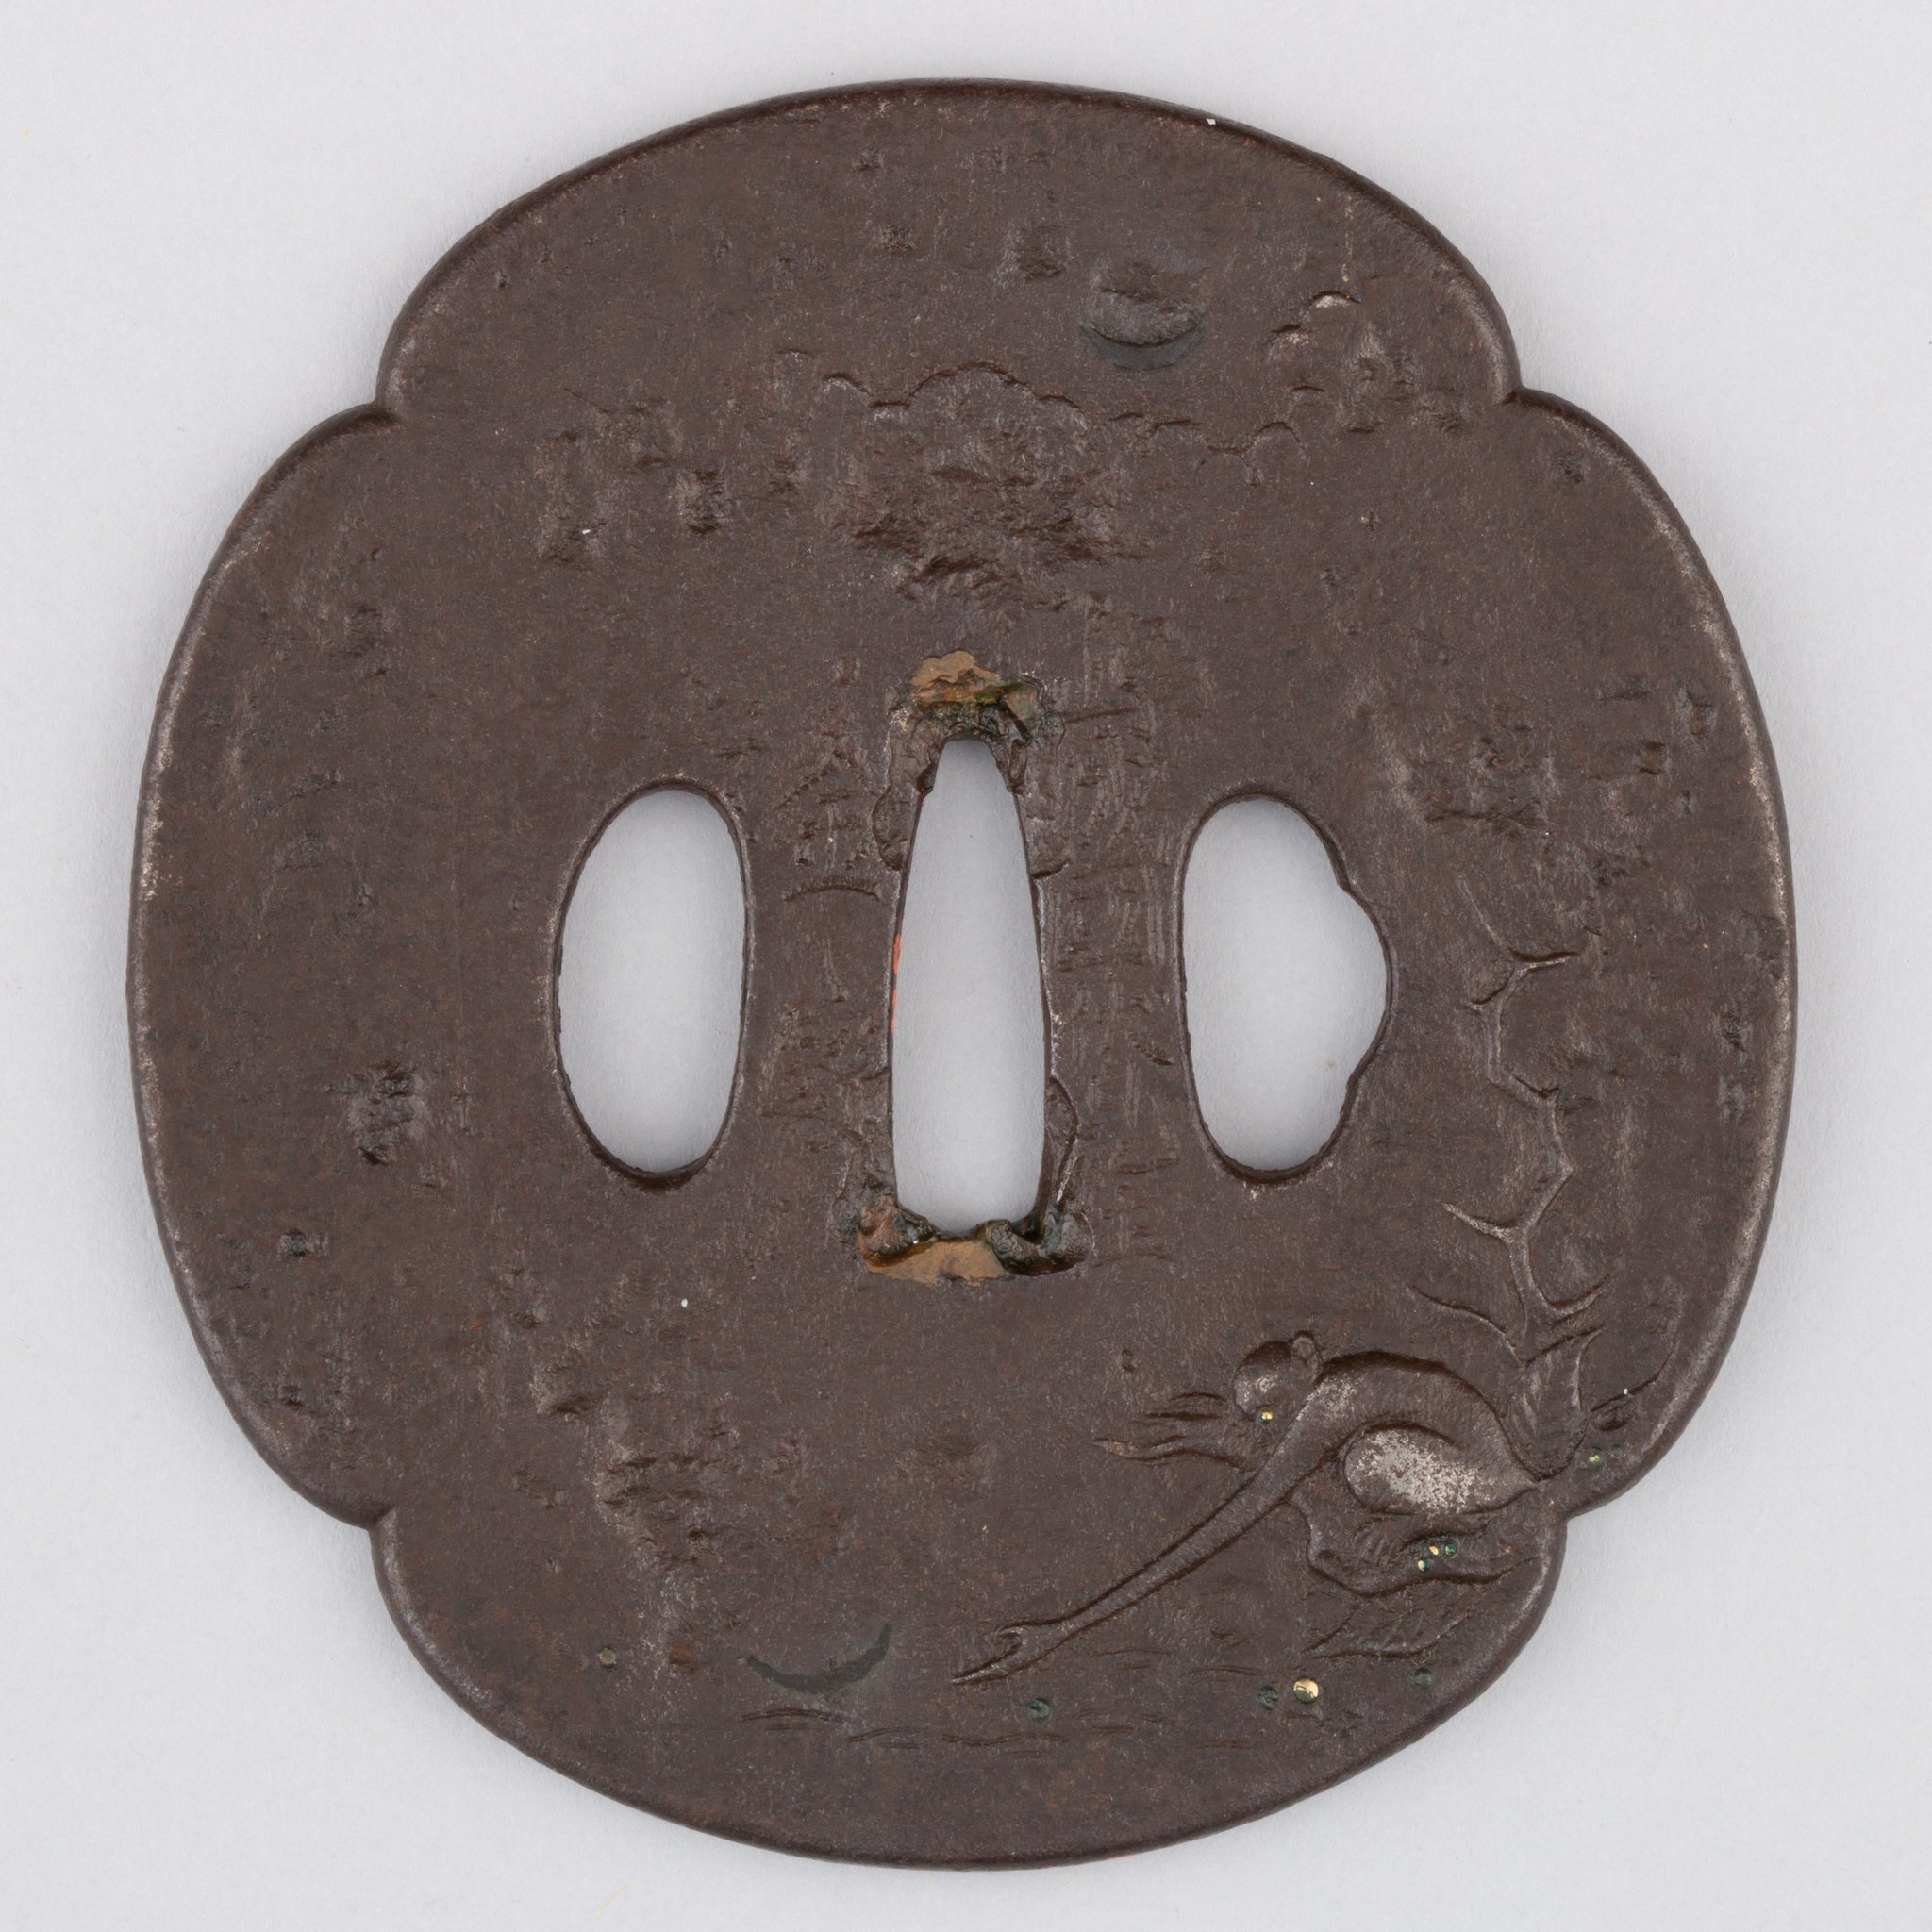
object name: sword guard tsuba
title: Sword Guard (Tsuba)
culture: japanese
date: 1615-1868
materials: copper, iron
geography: japan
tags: monkeys